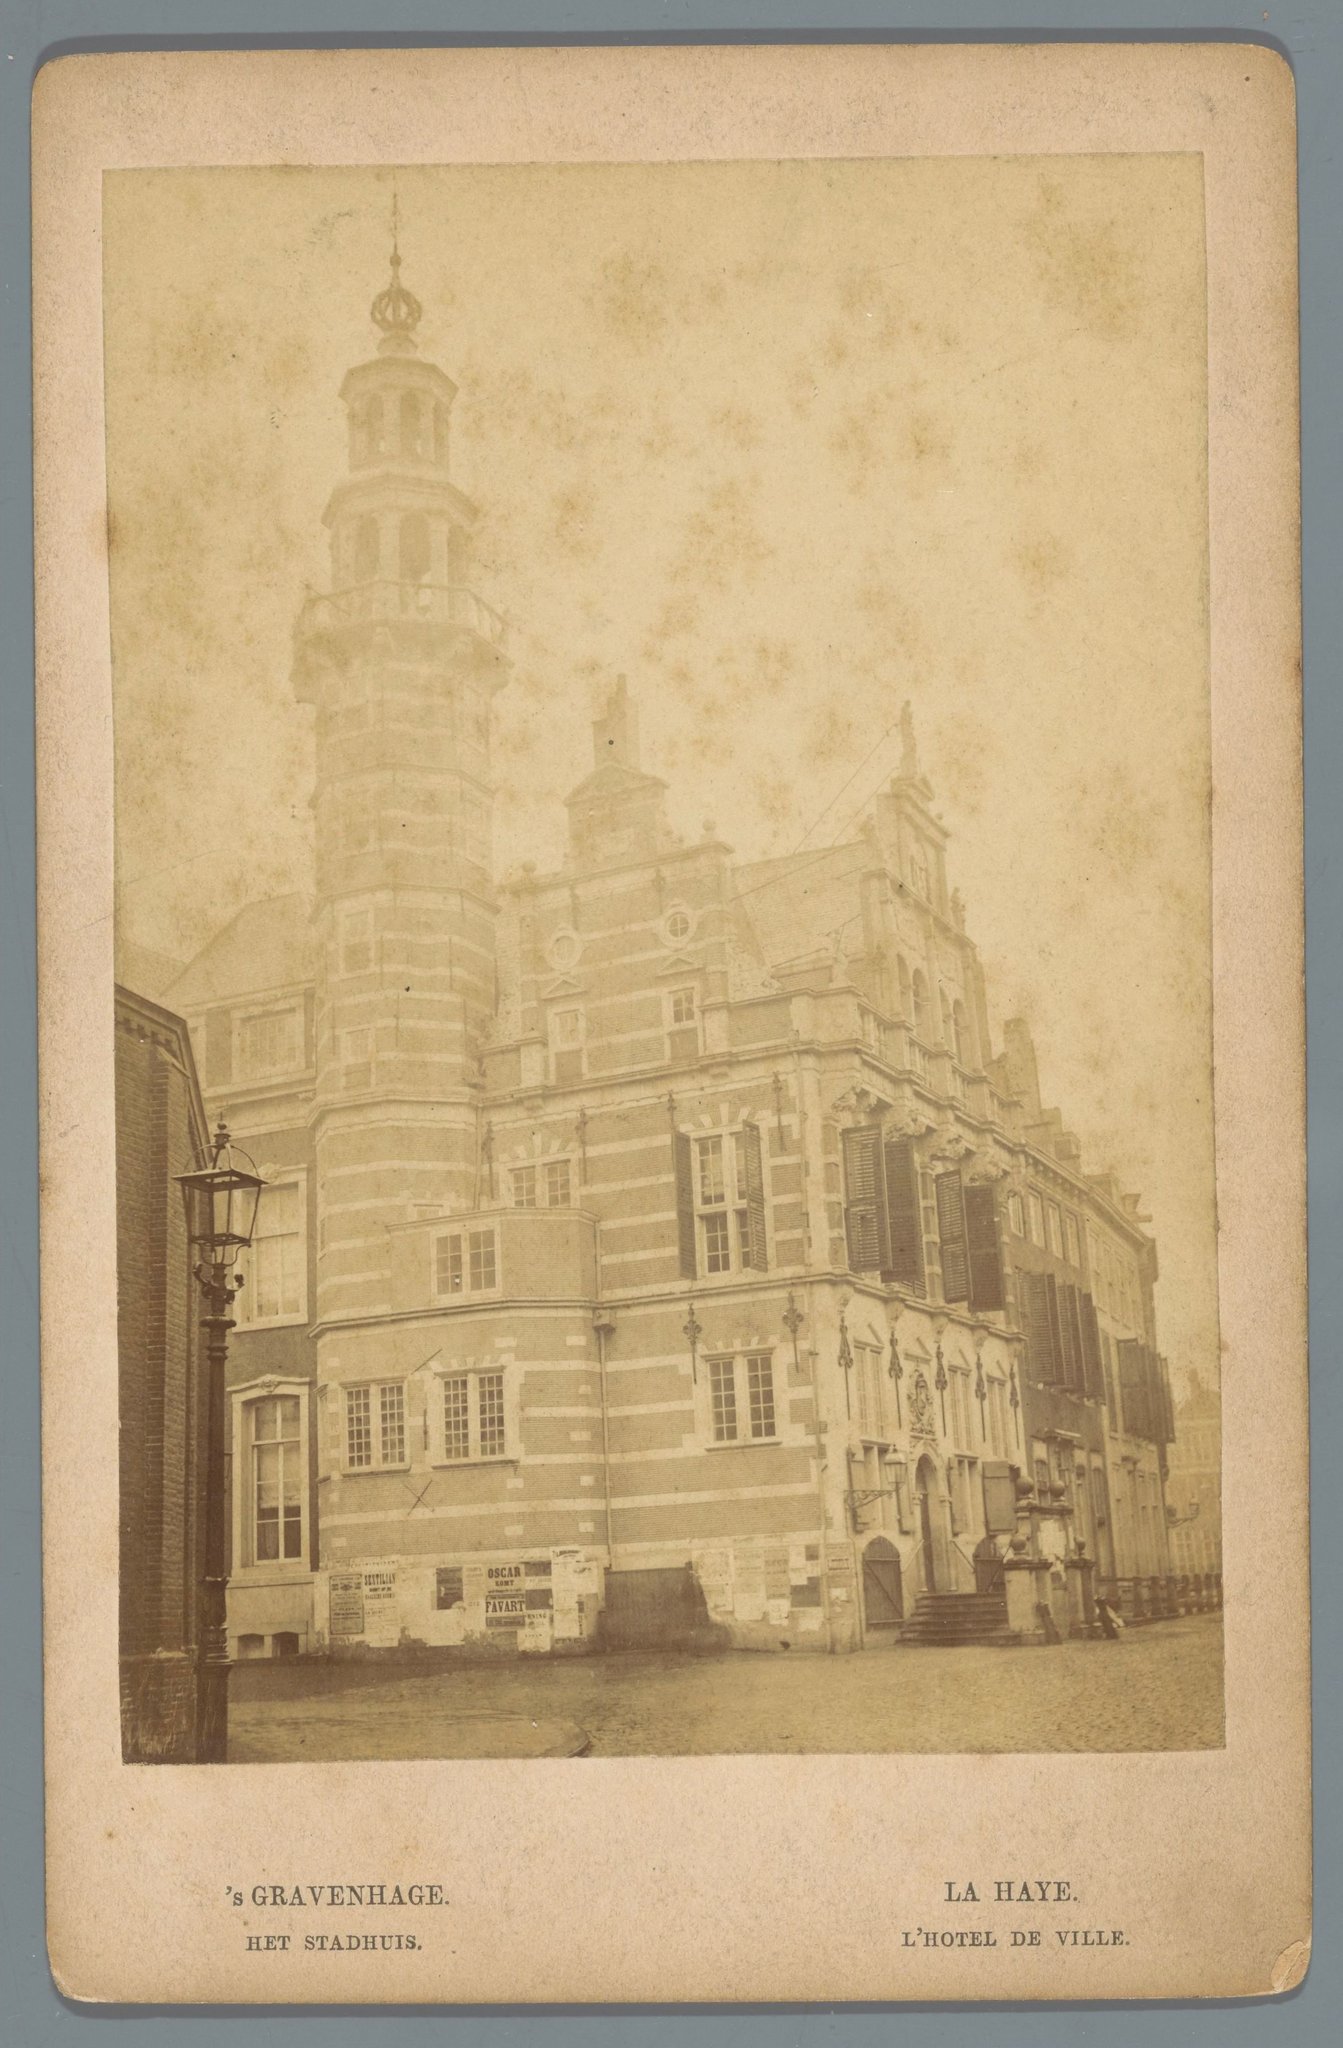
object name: cabinet photograph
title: 's Gravenhage, Het Stadhuis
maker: Anonymous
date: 1870-1890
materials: cardboard, photographic support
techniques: albumen print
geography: the hague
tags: townhall, façade (of house or building)